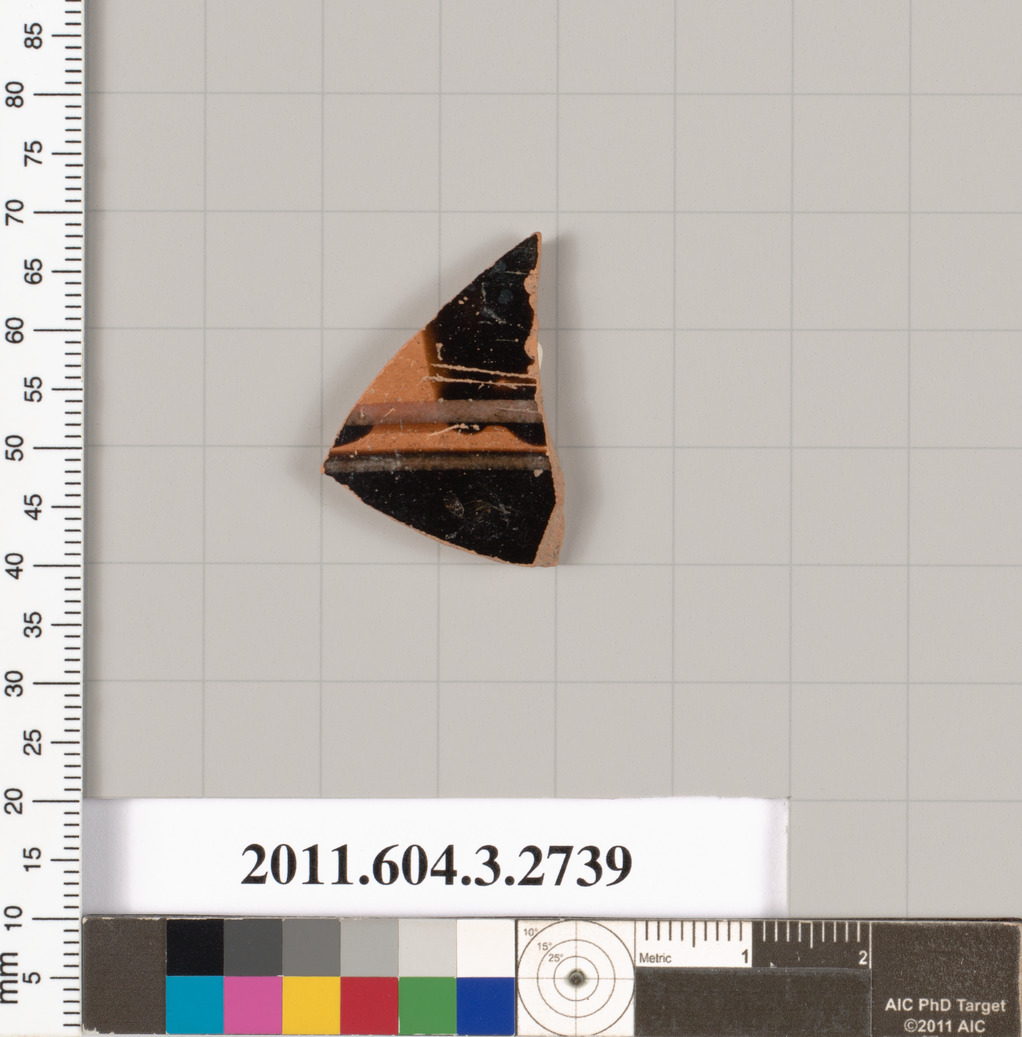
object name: olpe fragment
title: Terracotta fragment of an olpe (jug)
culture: greek, attic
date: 534-468 BCE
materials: terracotta